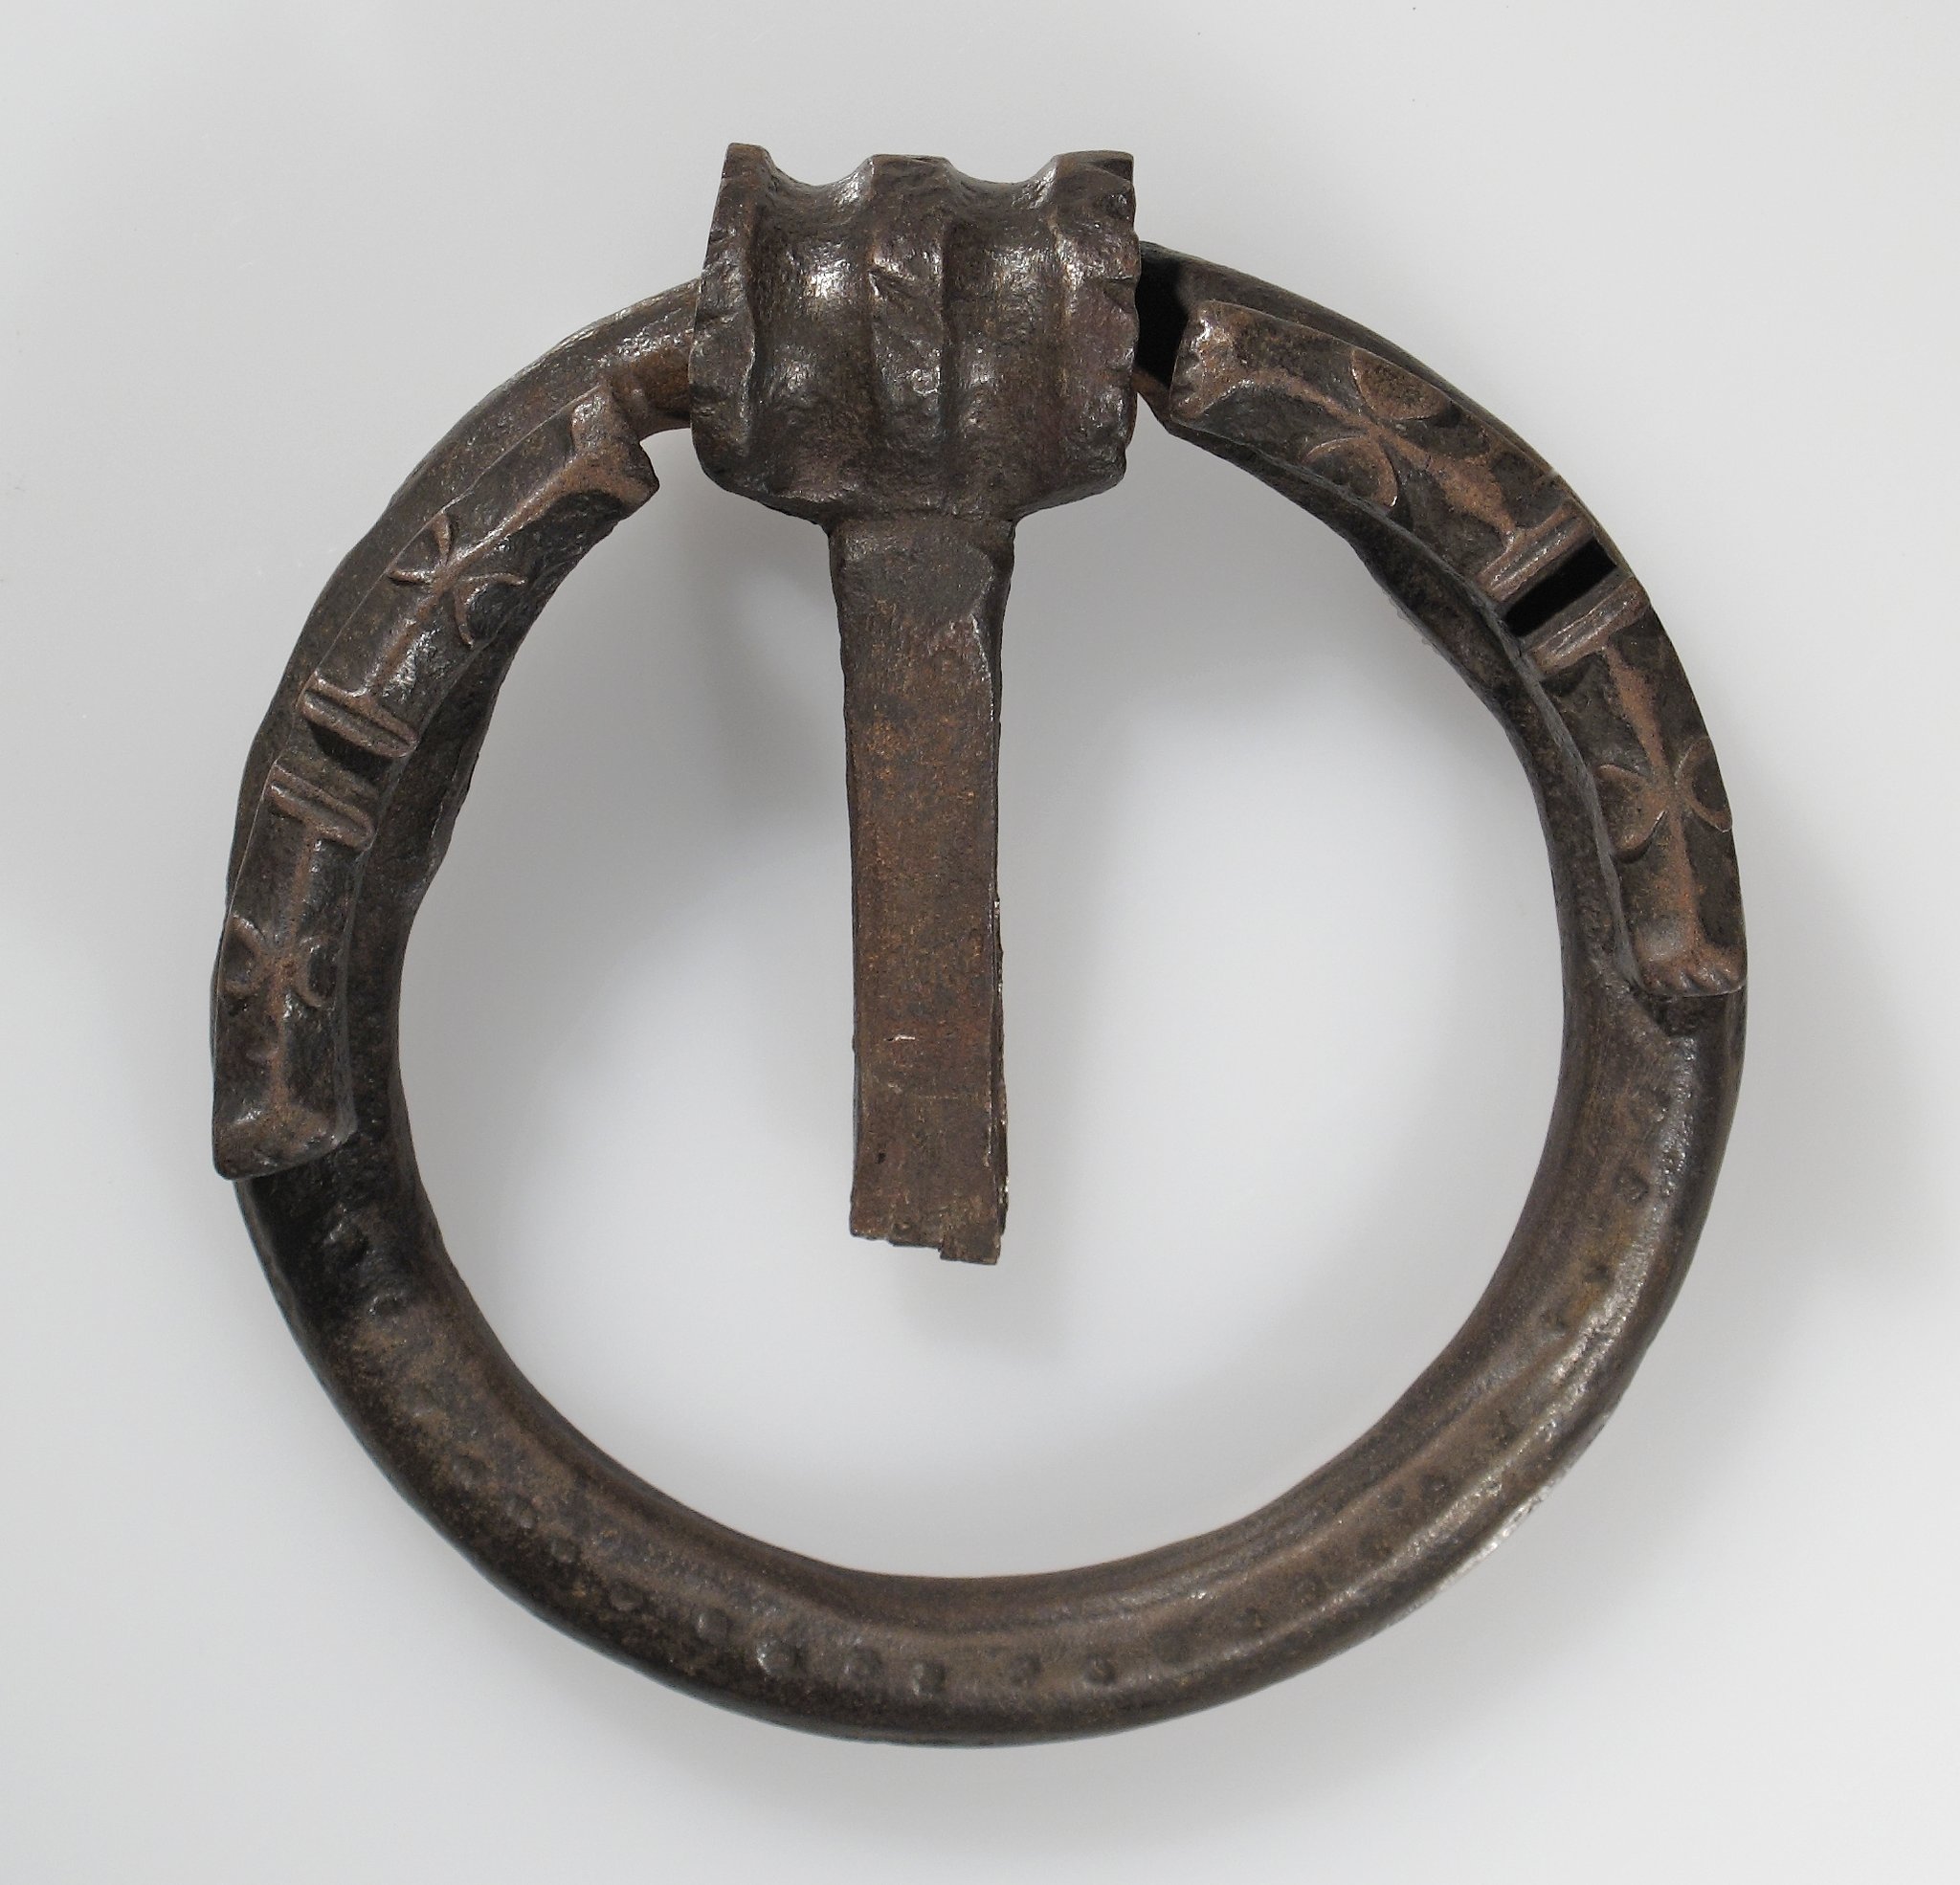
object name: door knocker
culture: european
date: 1401-1600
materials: iron